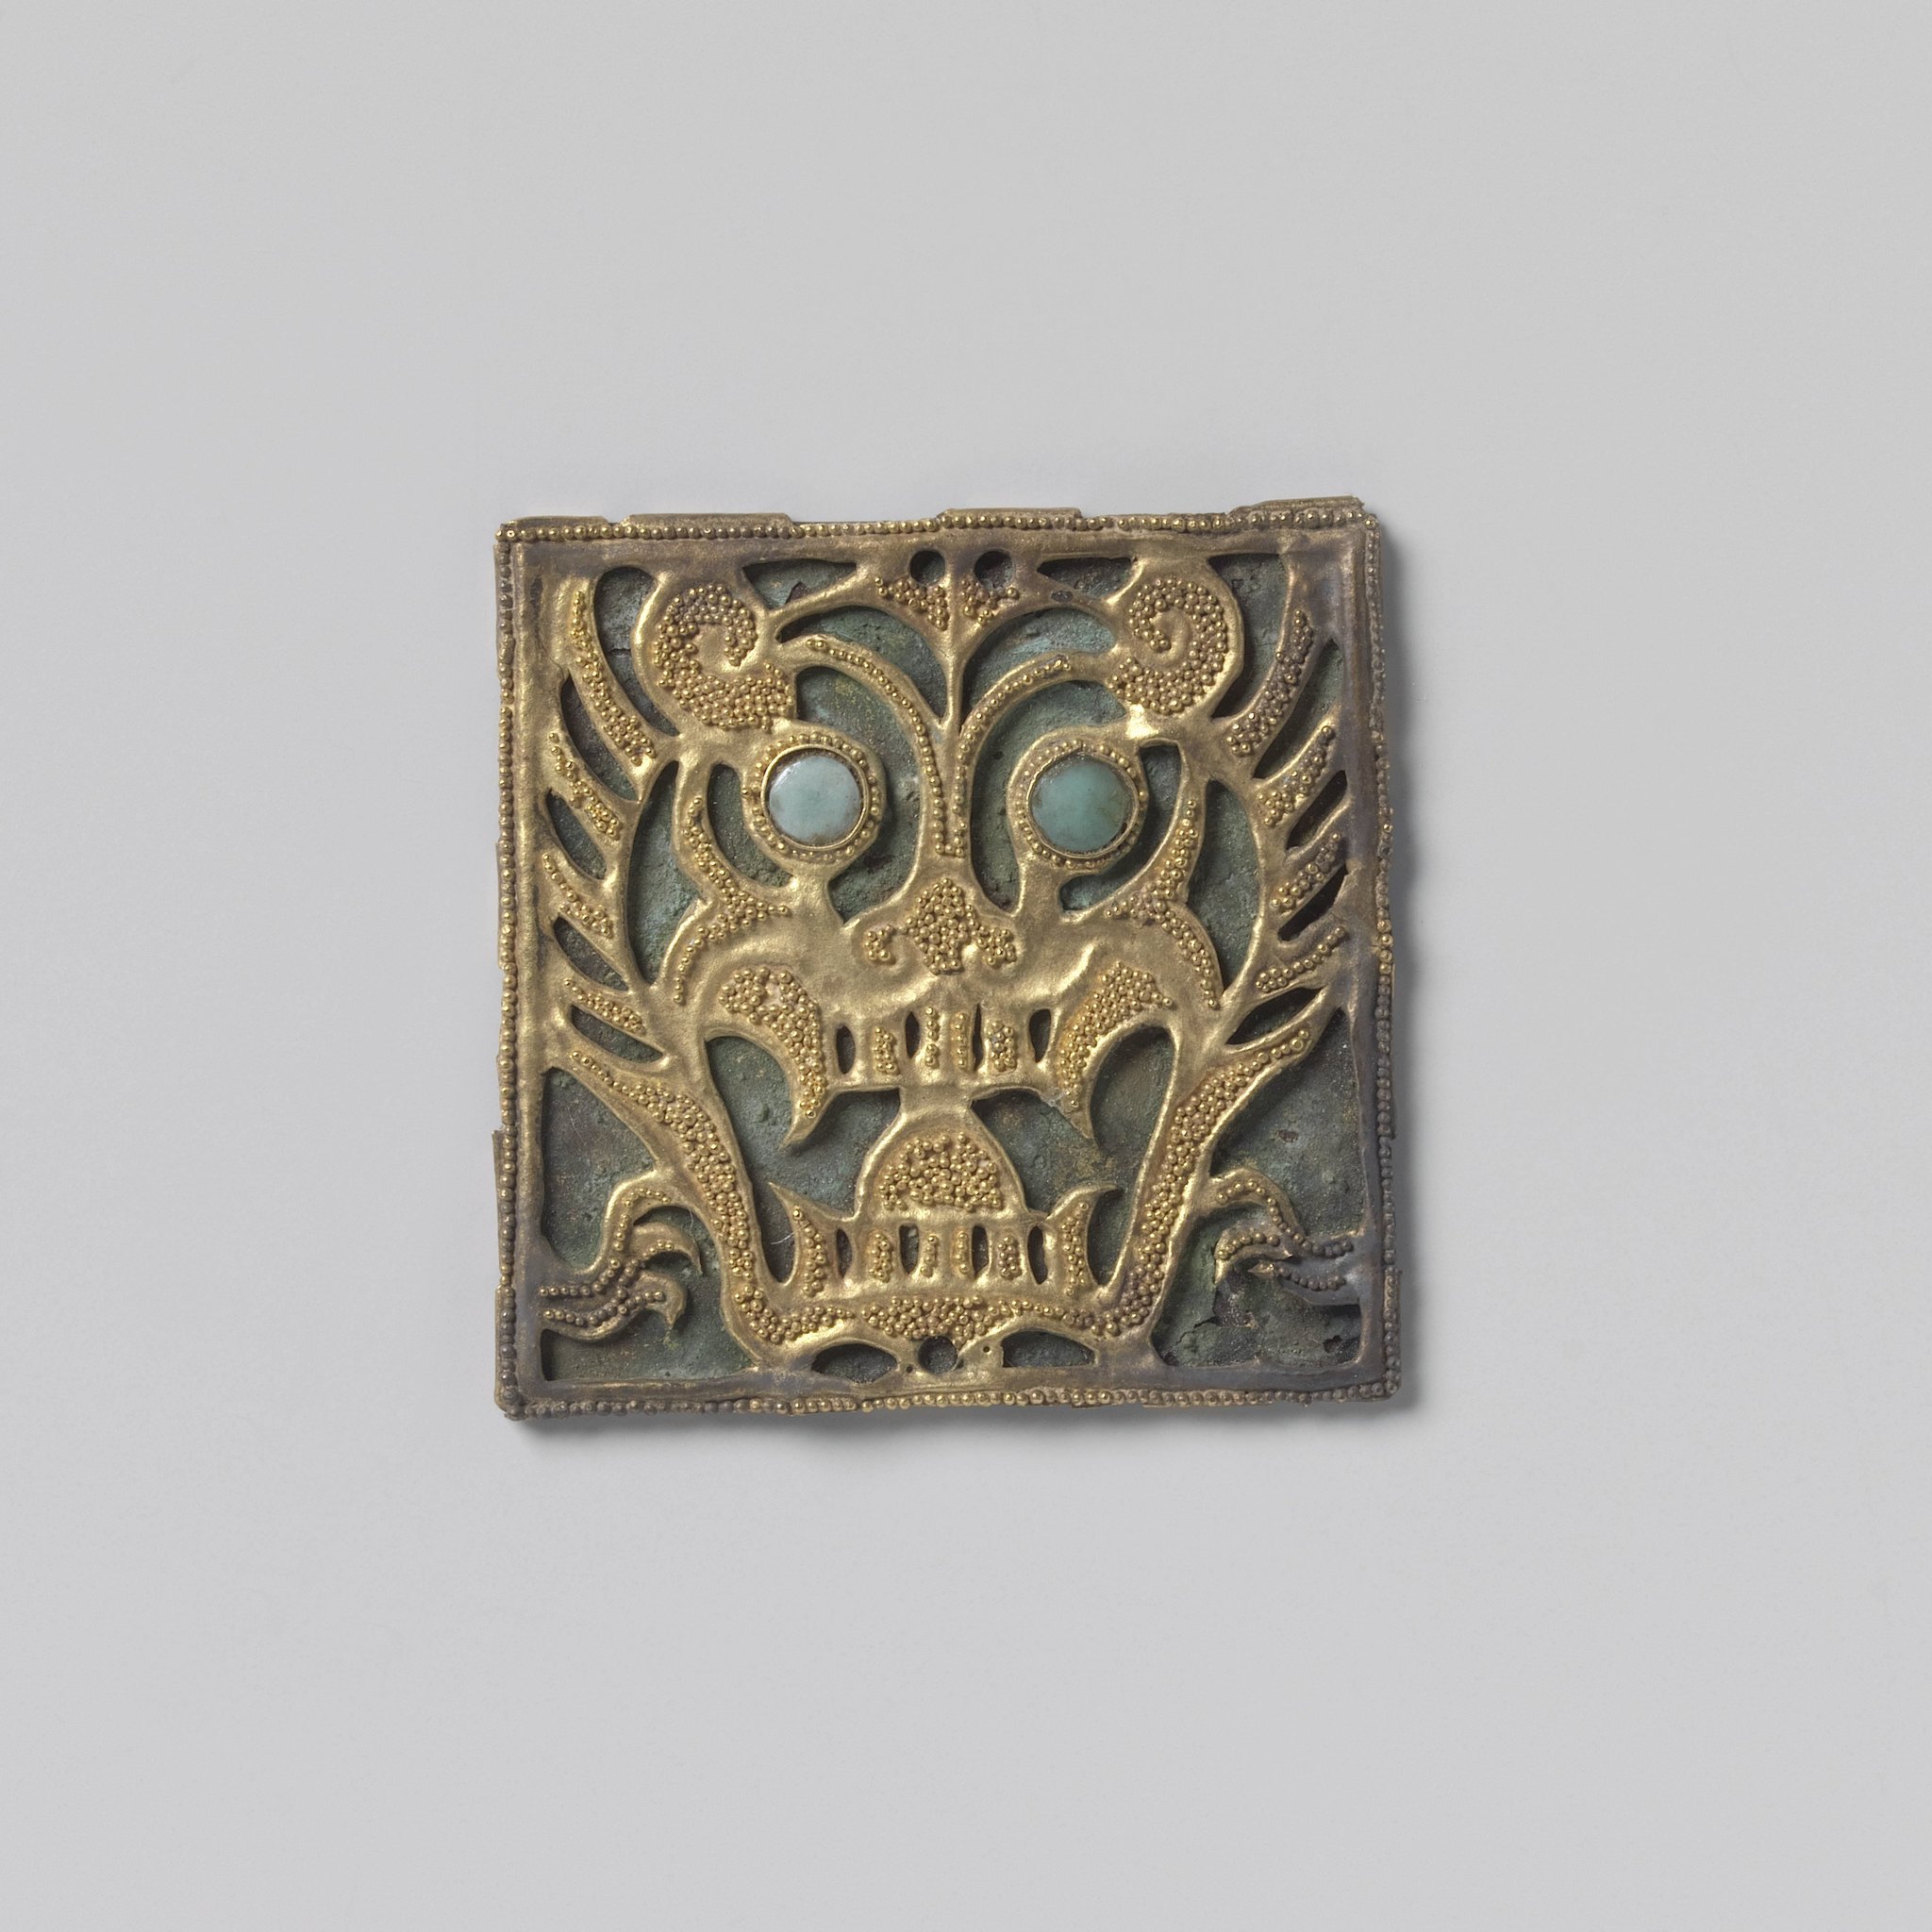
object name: appliqué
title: Clothing Ornament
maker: Anonymous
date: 350-450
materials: gold, gemstone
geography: china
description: Applique, a-jour bewerkt en in granulatie-techniek versierd.